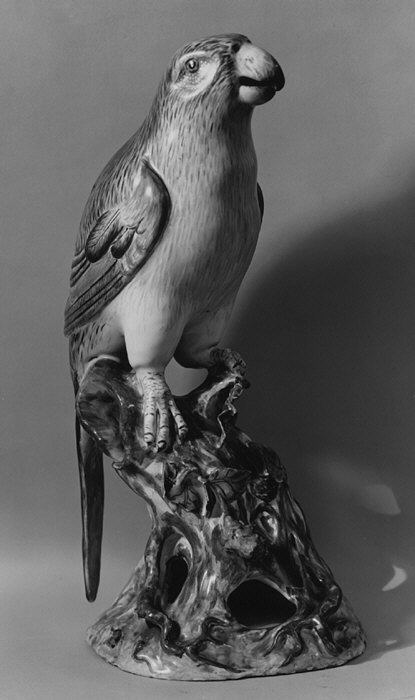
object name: figure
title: Parrot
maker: johannes zeschinger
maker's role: maker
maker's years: 1723-1823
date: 1750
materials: faience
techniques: glazing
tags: parrots